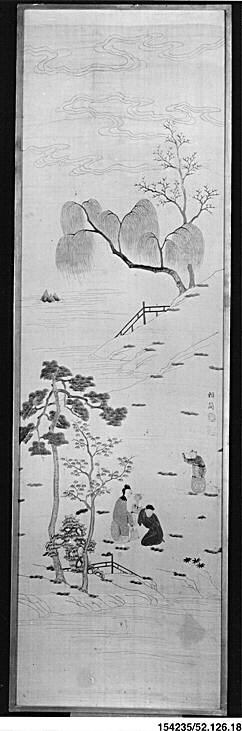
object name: screen panel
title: Screen Panel from Set of Six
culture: chinese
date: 1767-1833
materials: silk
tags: human figures,trees